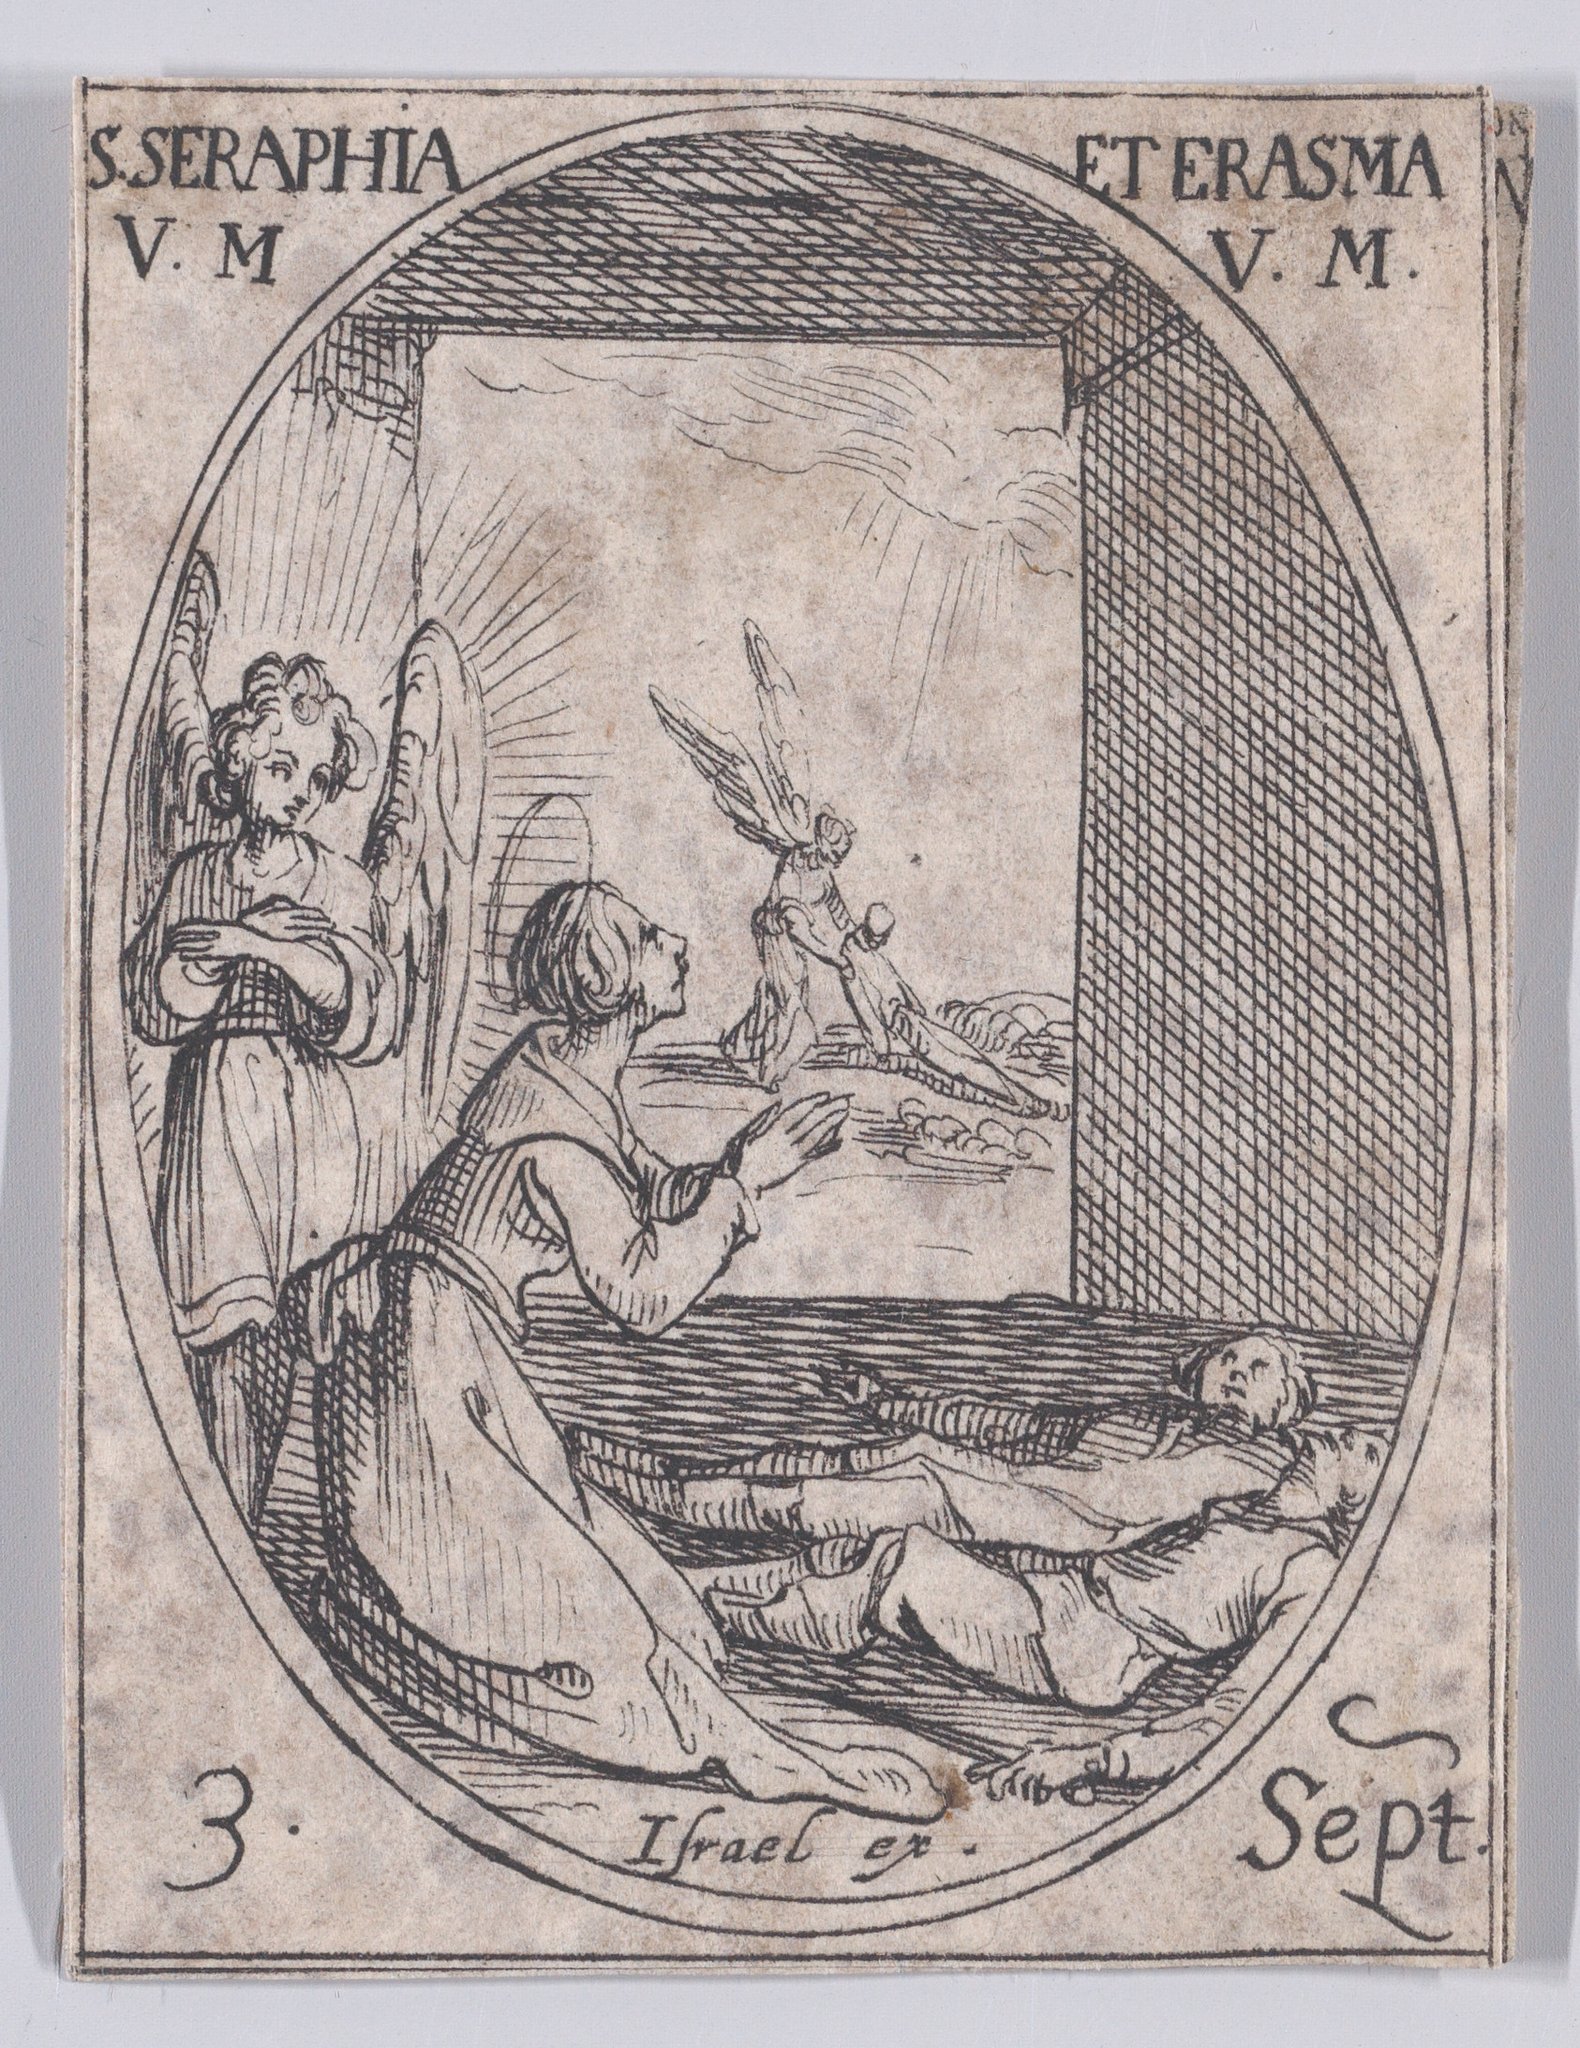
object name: print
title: Ste. Séraphie et Ste. Erasme, vierges et martyres (St. Seraphia and St. Erasma, Virgins and Martyrs), September 3rd, from "Les Images De Tous Les Saincts et Saintes de L'Année" (Images of All of the Saints and Religious Events of the Year)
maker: jacques callot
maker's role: artist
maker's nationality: french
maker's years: 1592-1635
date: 1636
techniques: etching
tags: women,angels,saints